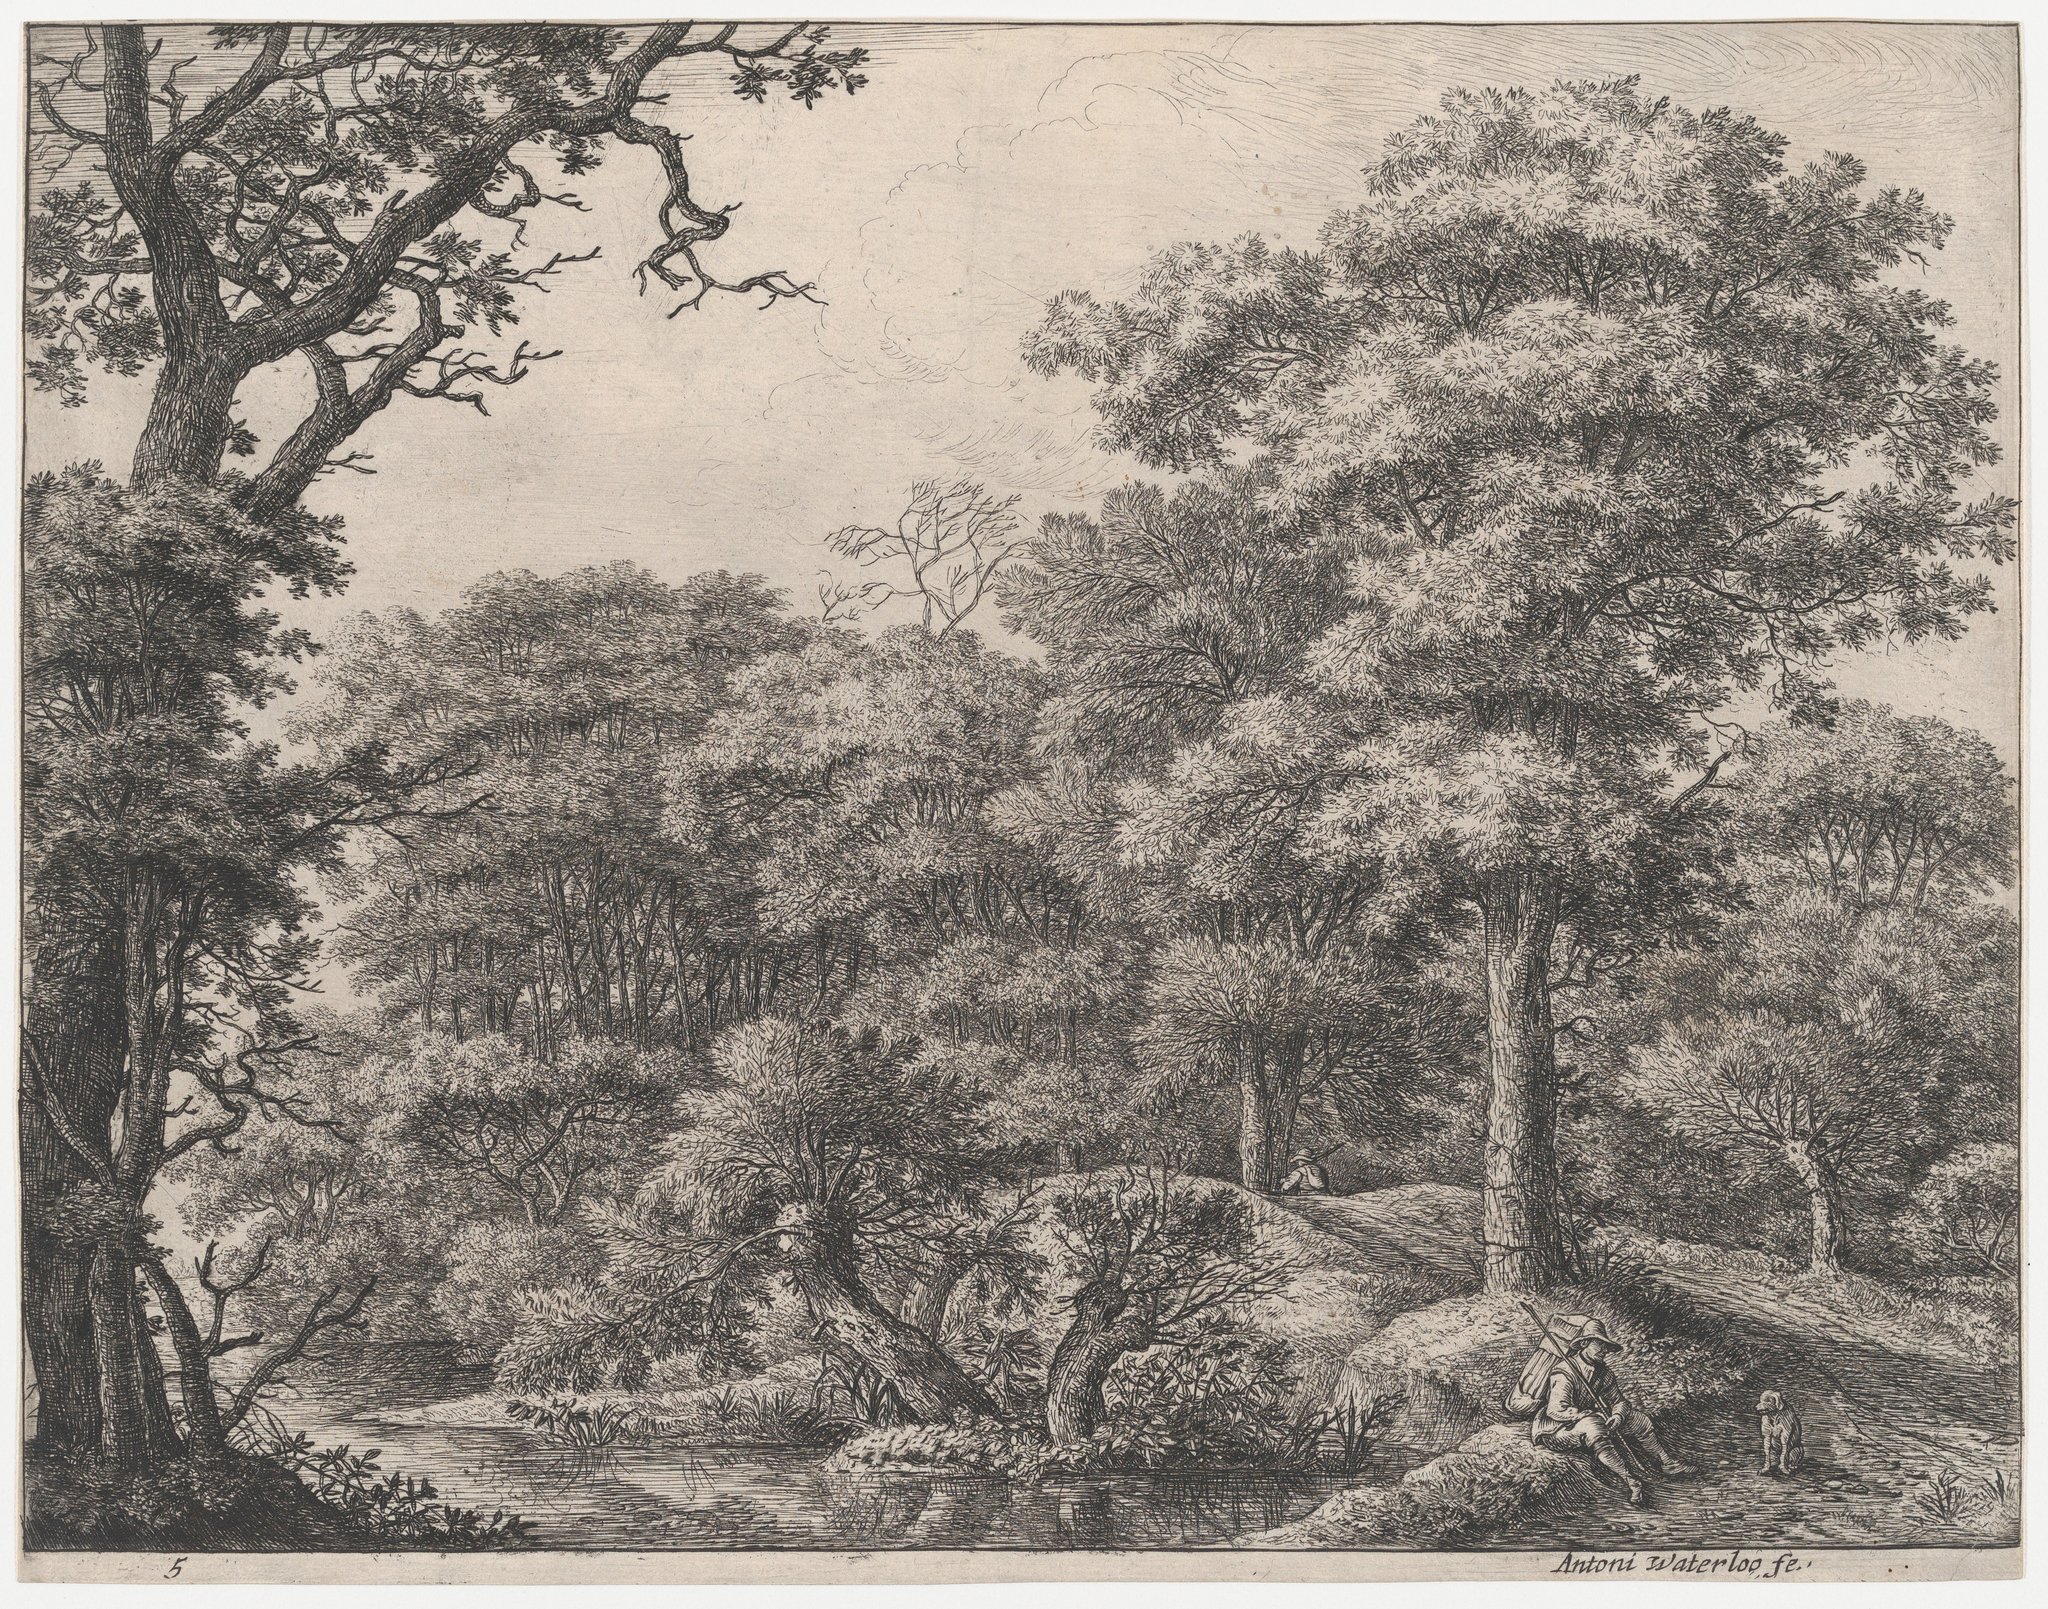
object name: print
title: Travelers Resting in the Forest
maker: anthonie waterloo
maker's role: artist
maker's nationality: dutch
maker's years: 1609-1690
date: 1601-1700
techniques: etching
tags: human figures,forests